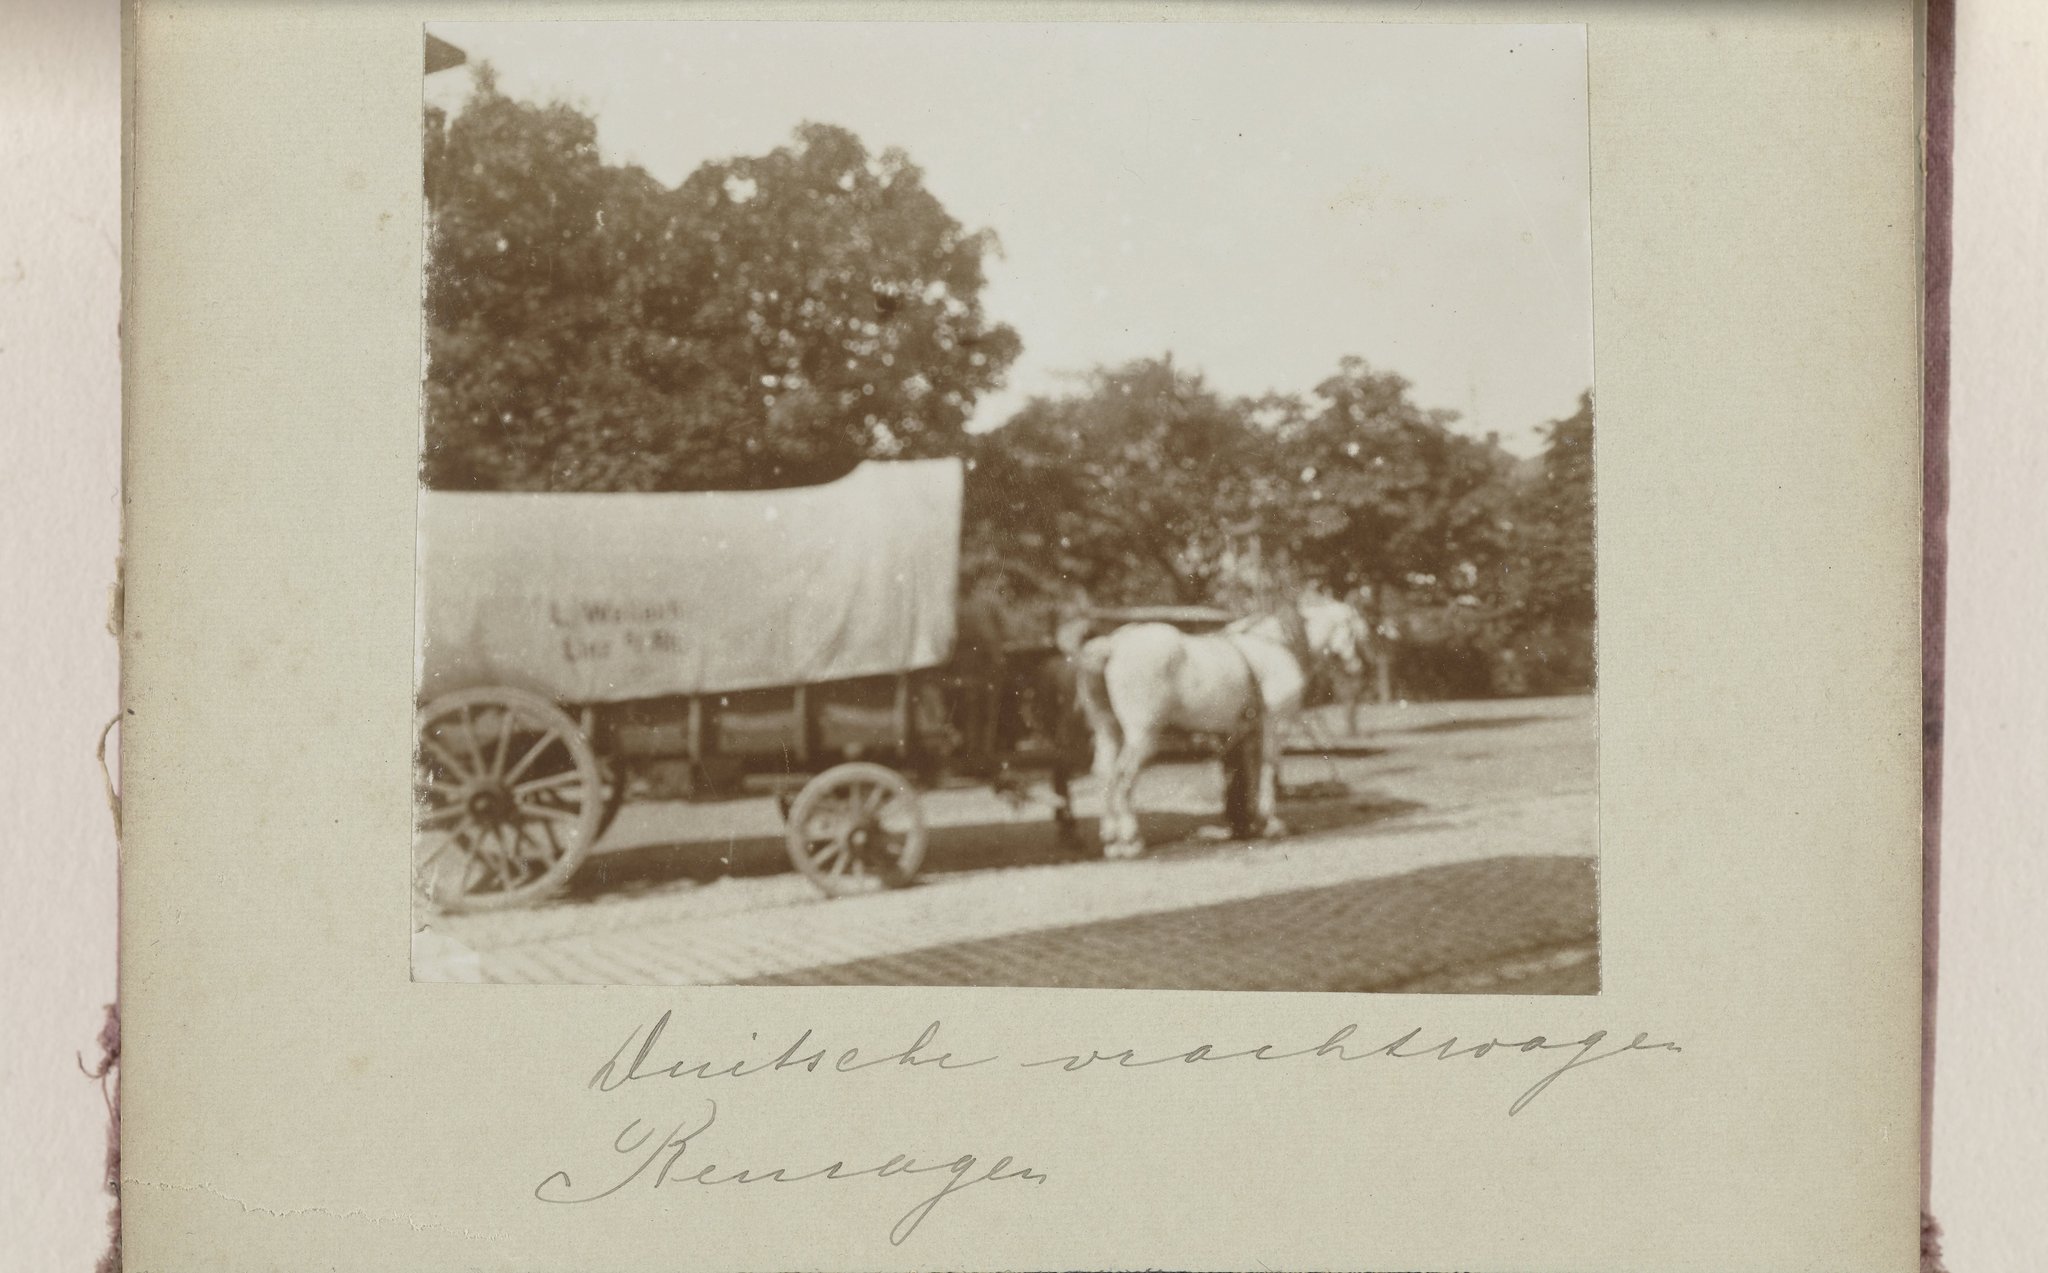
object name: album leaf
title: Duitsche vrachtwagen Remagen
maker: david vermeulen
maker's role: fotograaf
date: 1895-1905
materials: paper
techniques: collodion silver print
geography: remagen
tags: four-wheeled vehicle drawn by two animals